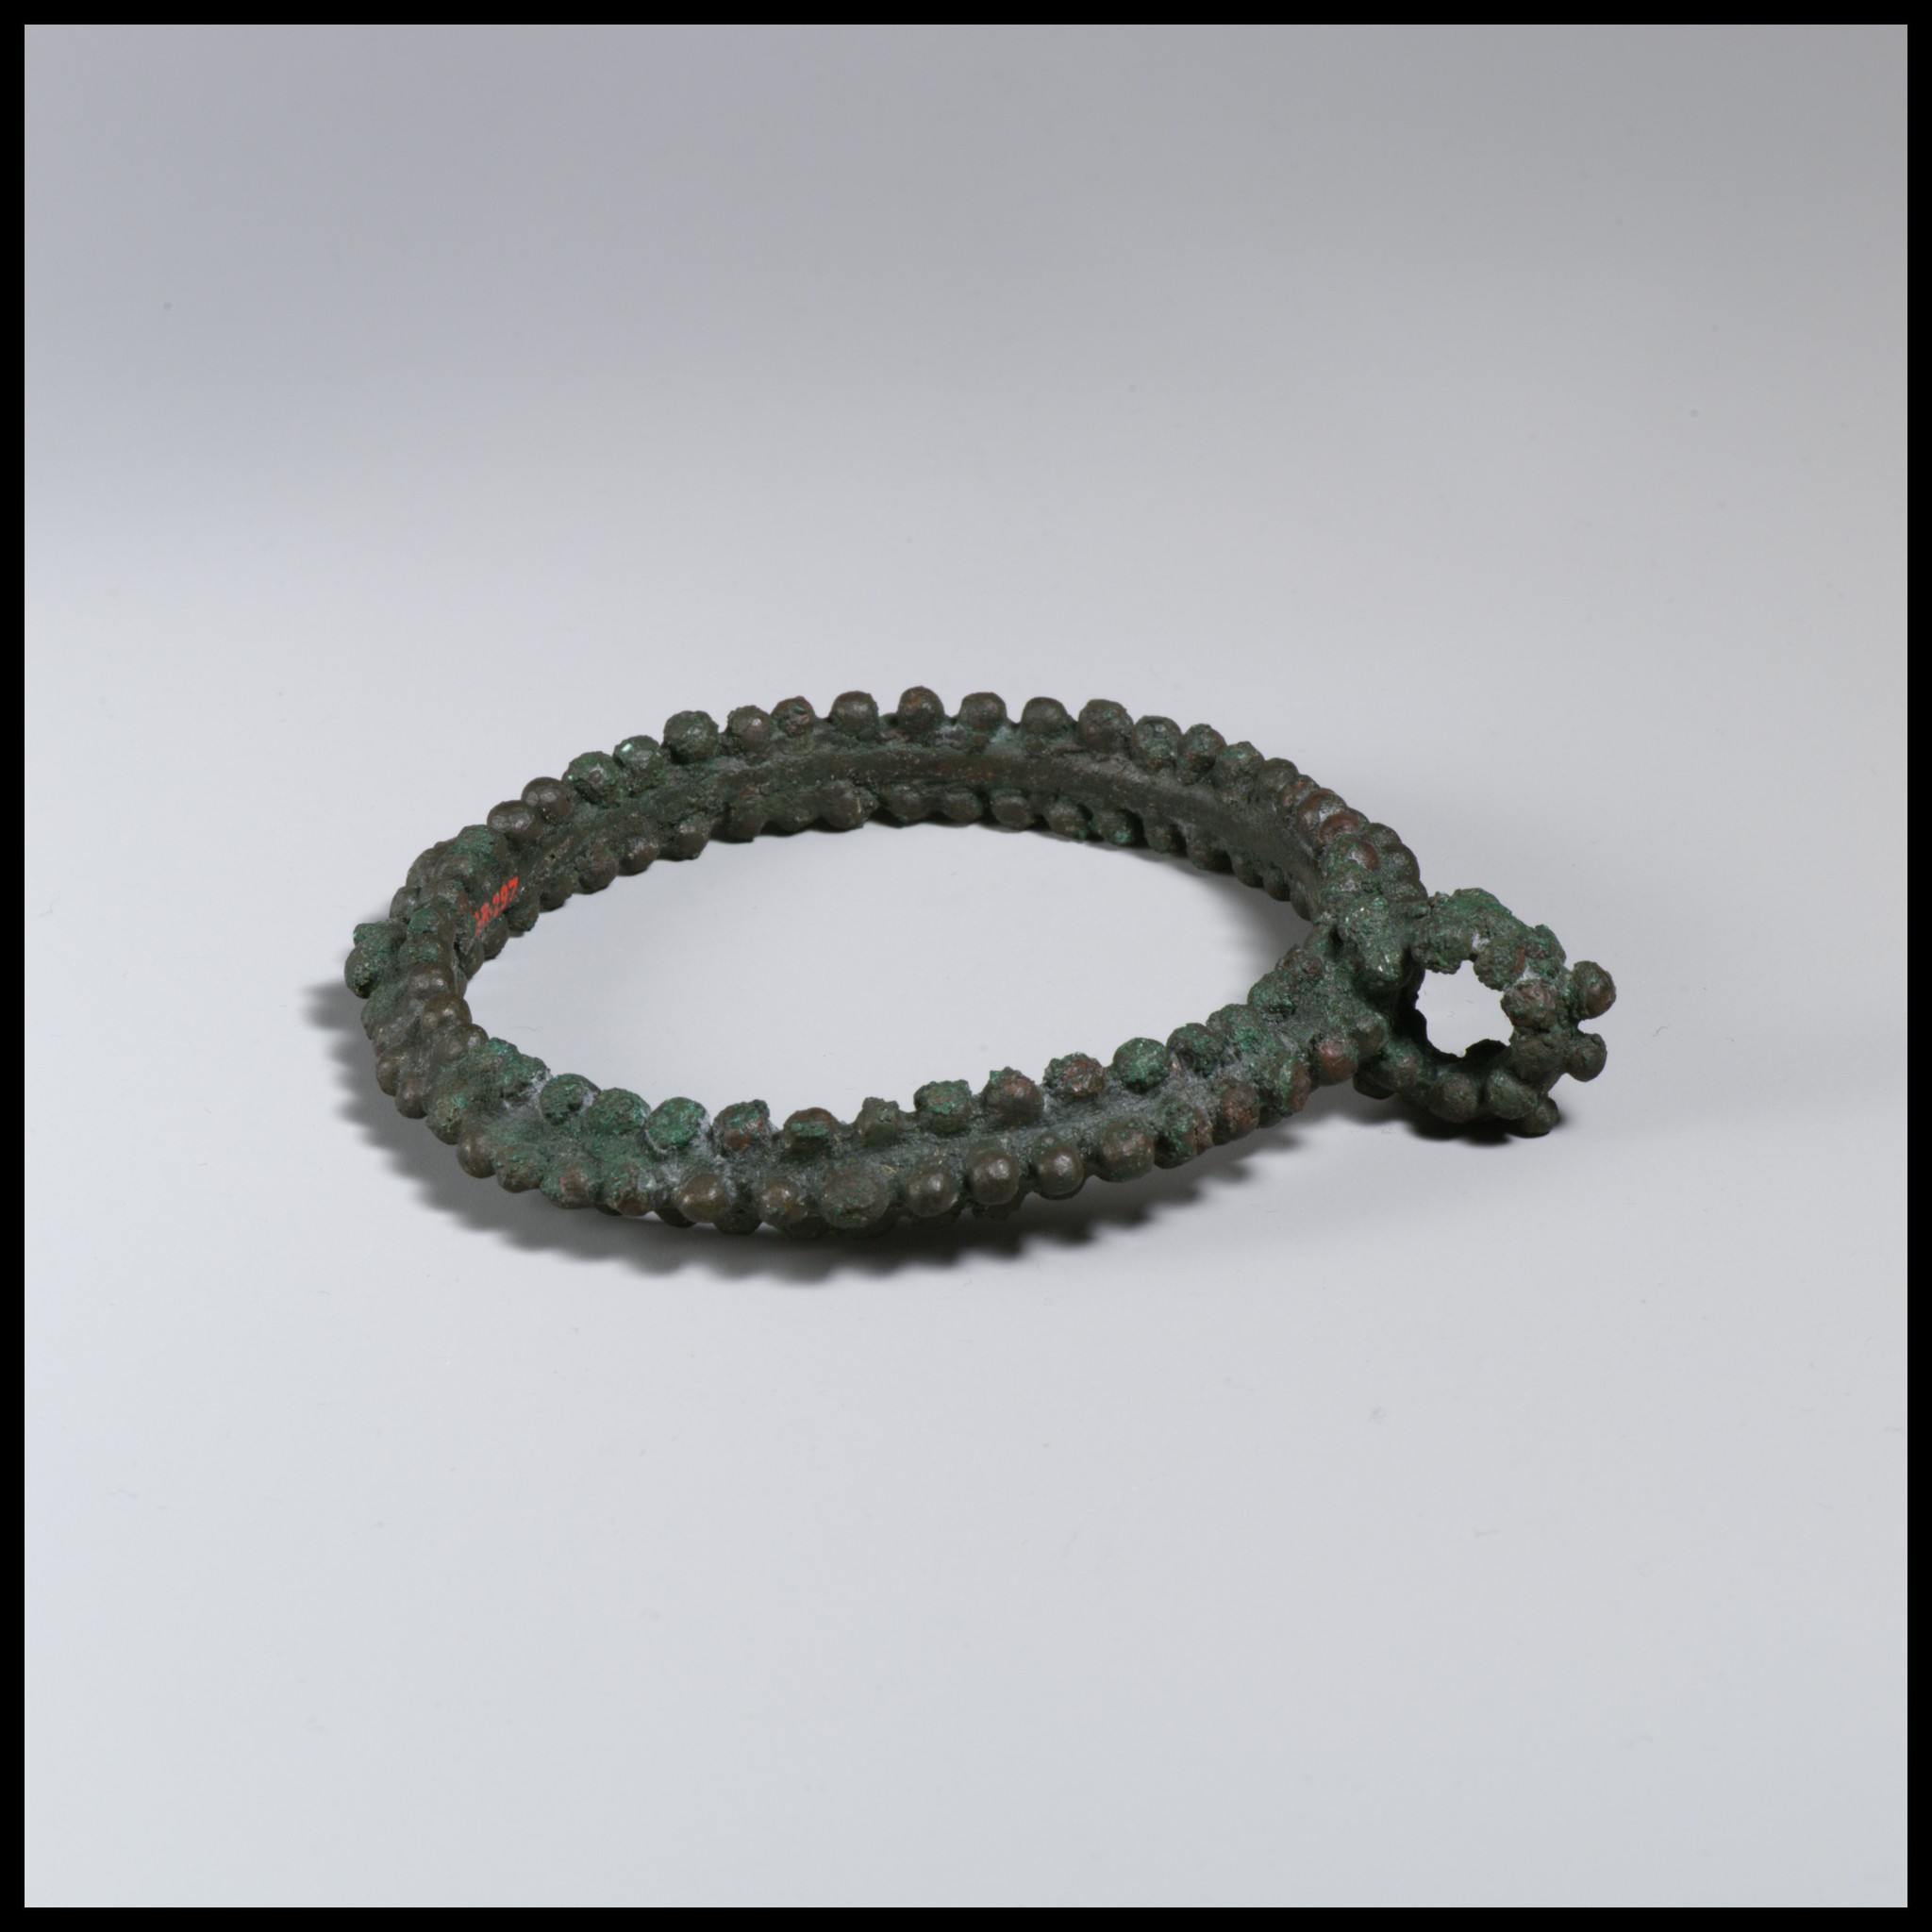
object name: bracelet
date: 7000 BCE-330 CE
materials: bronze